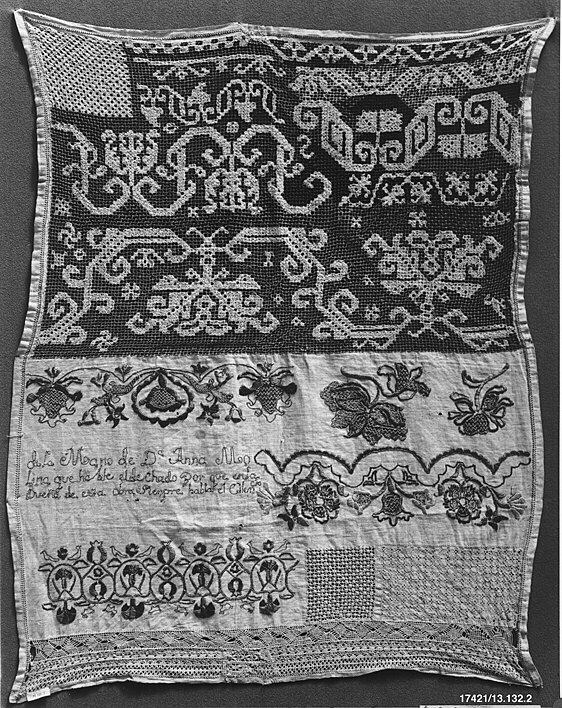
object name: sampler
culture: mexican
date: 1790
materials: linen, silk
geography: spain